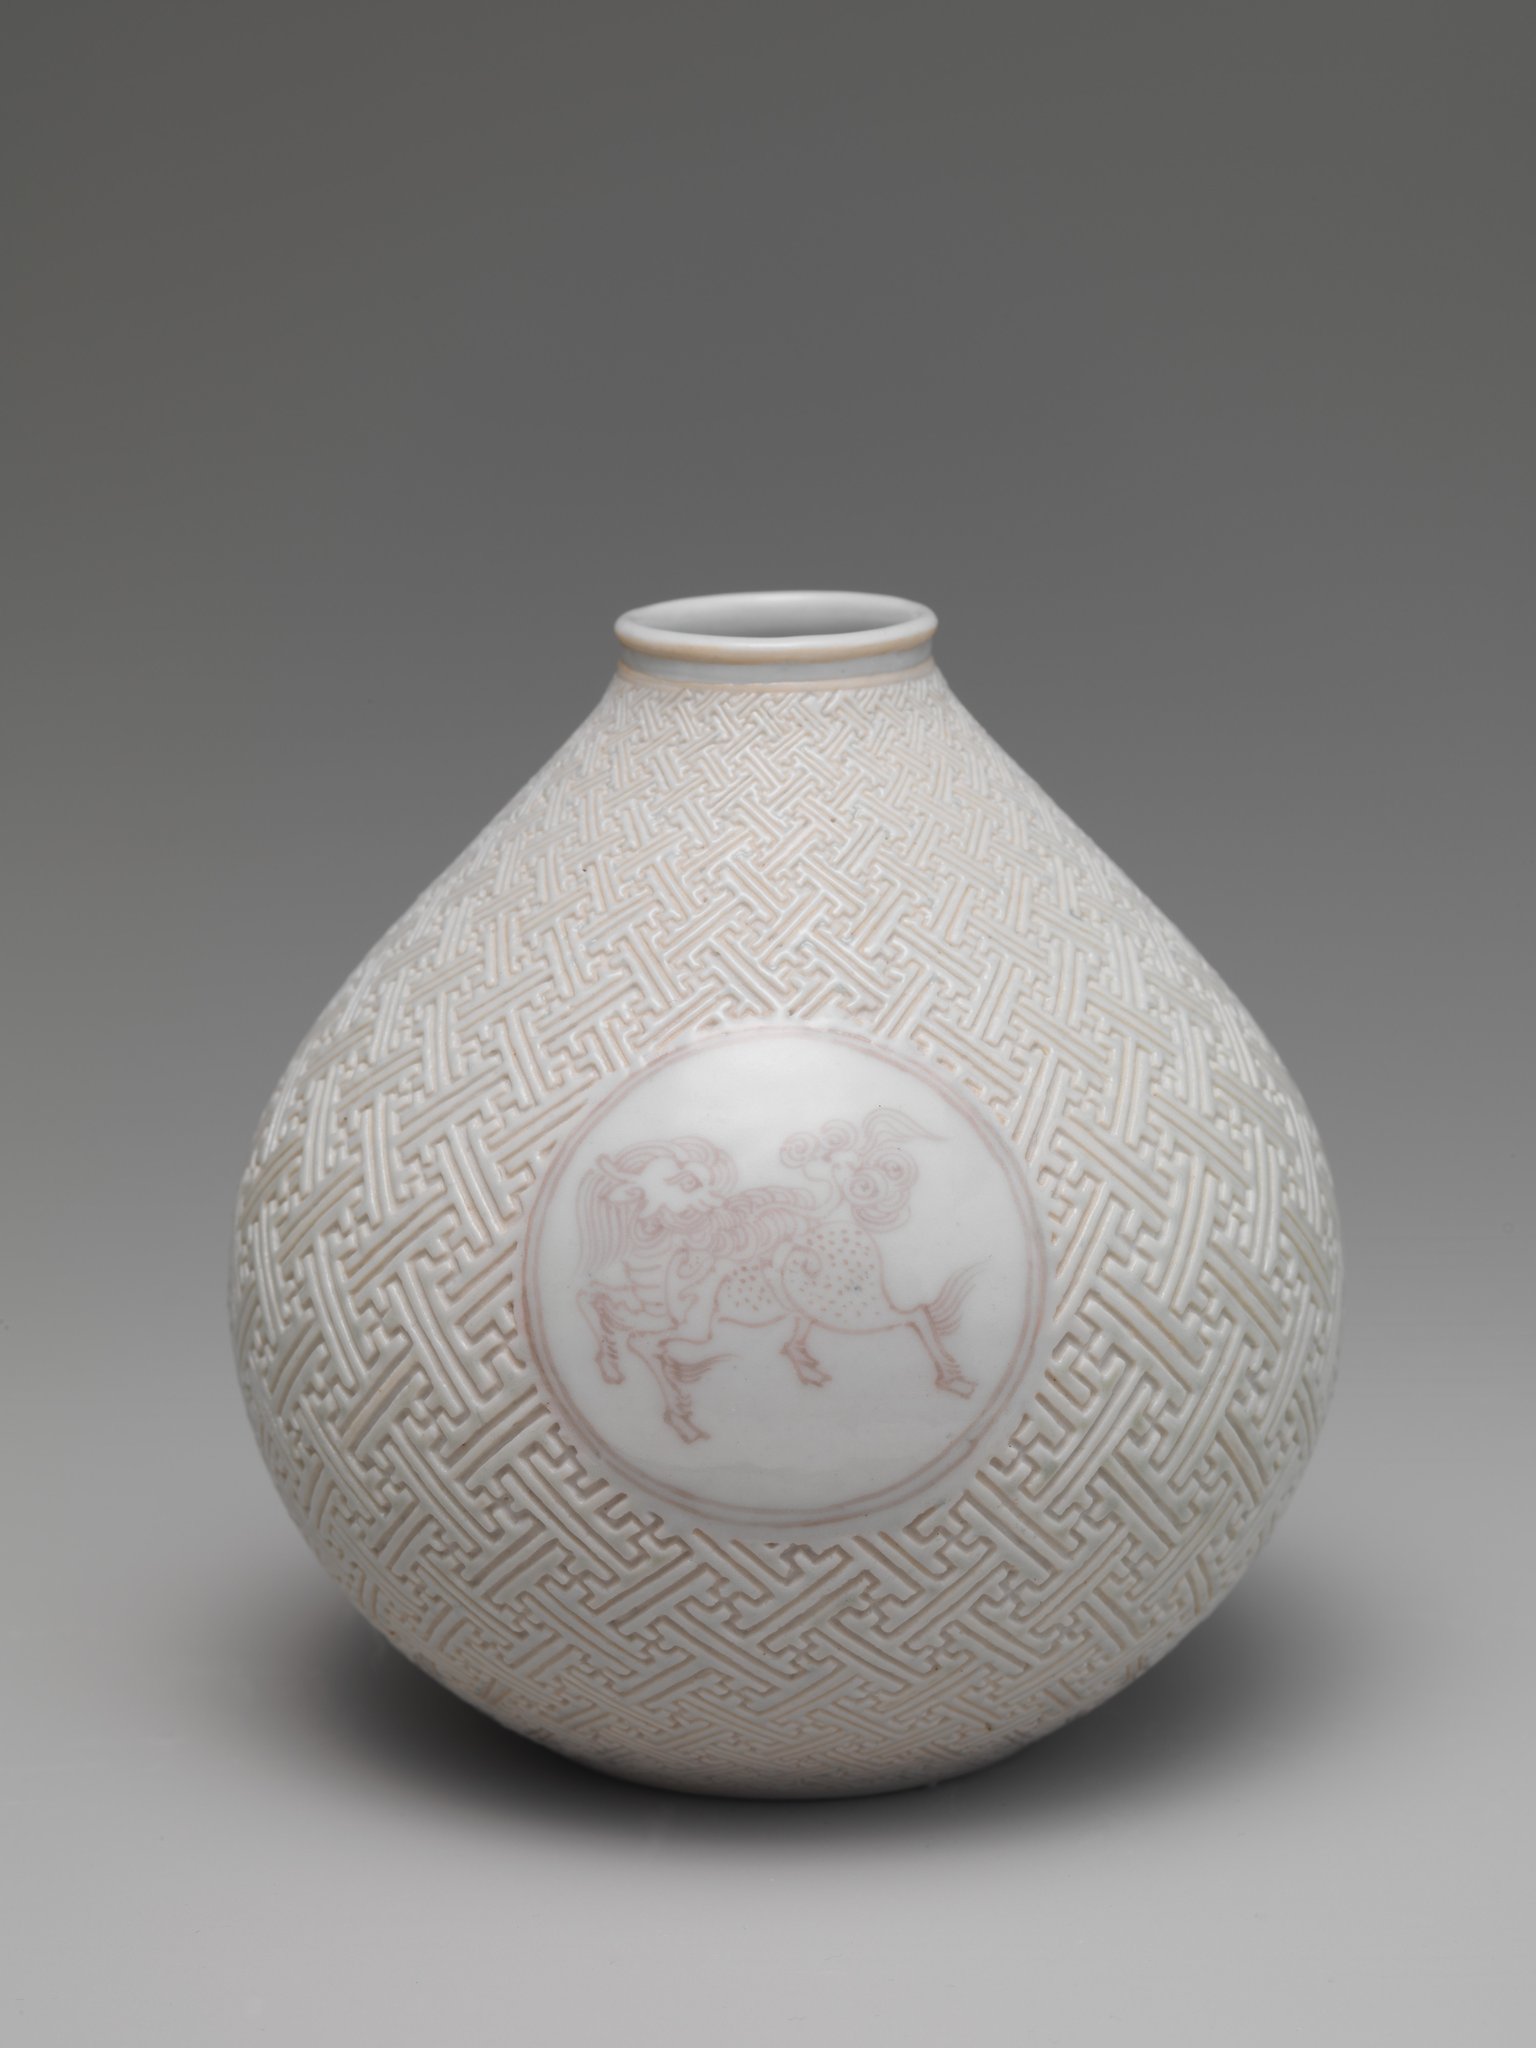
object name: flower vase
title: Vase with Horse and Kirin on Geometric Sayagata (key fret) Pattern (one of a pair)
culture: japanese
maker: makuzu kōzan i (miyagawa toranosuke)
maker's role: artist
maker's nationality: japanese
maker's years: 1842-1916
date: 1867-1900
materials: porcelain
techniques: incising, underglaze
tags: horses